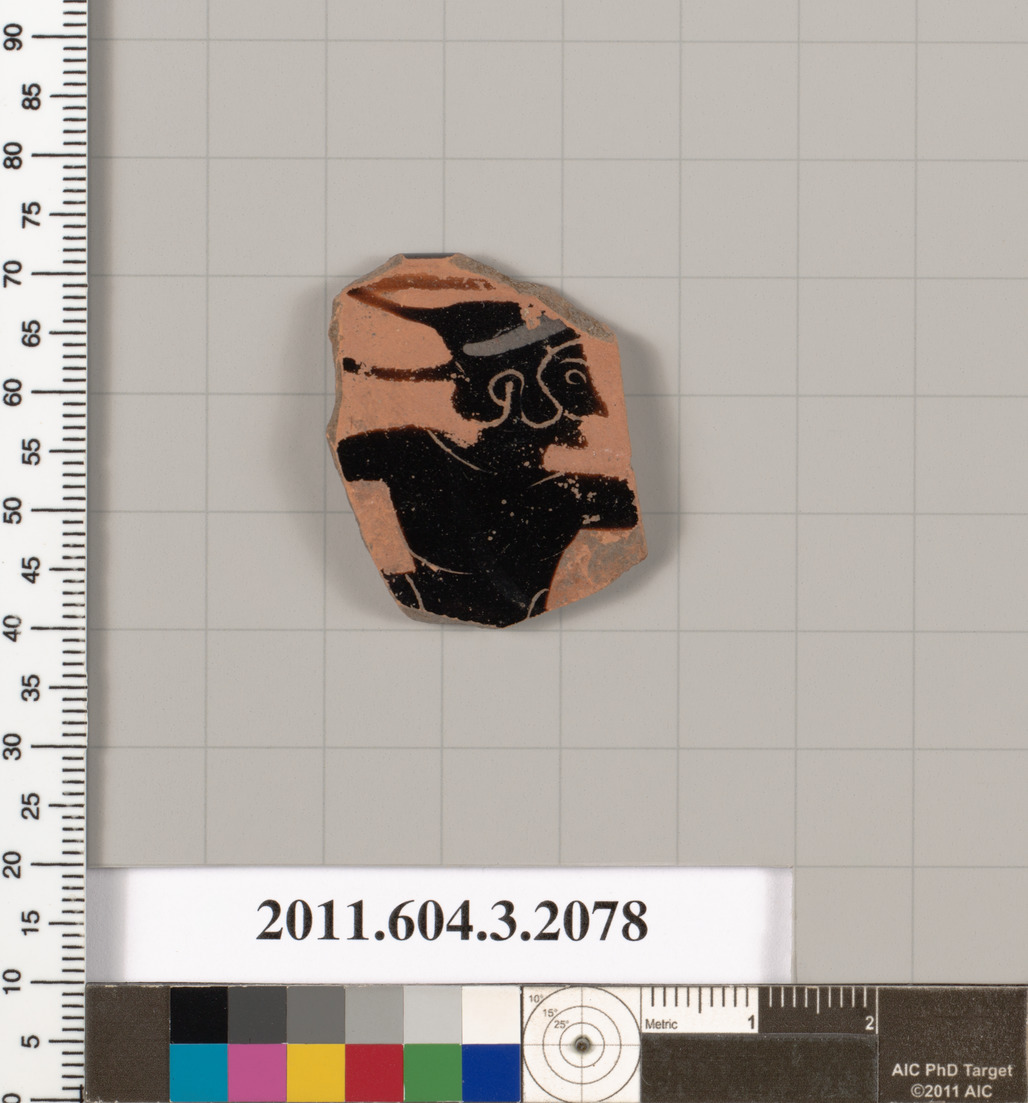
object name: kylix fragment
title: Terracotta rim fragment of a kylix (drinking cup)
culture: greek, attic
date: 534-501 BCE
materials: terracotta